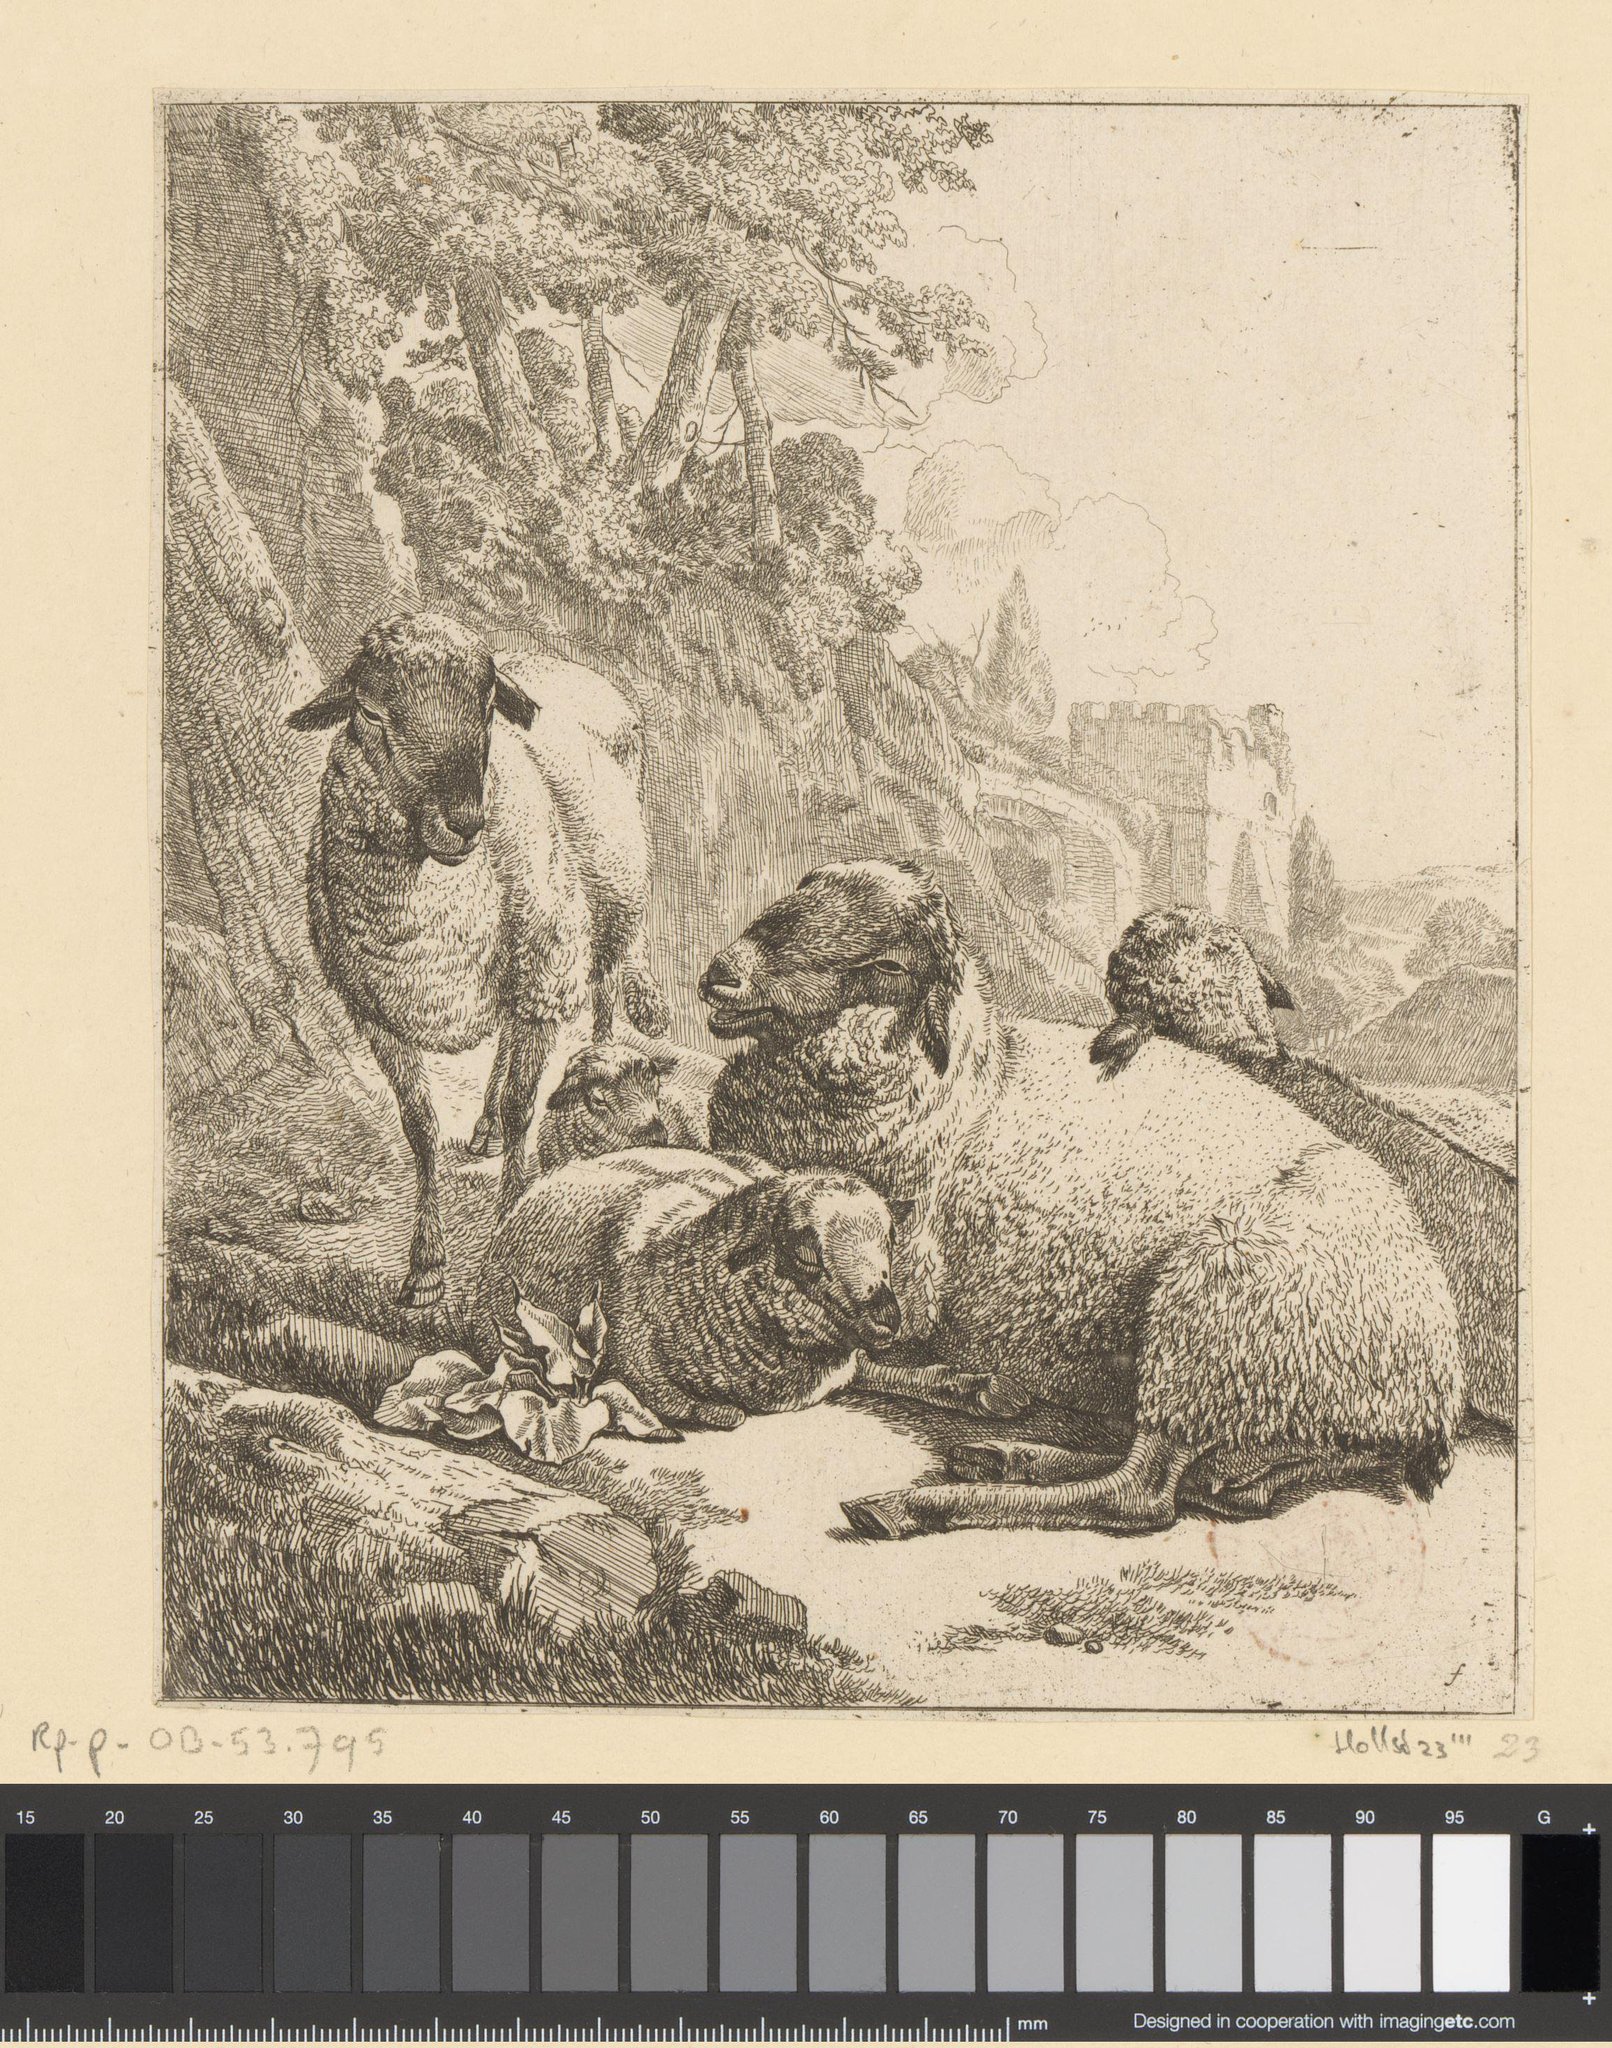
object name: print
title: Staand schaap en drie liggende schapen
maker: johann heinrich roos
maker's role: draughtsman, print maker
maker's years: 1631-1685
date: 1668-1670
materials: paper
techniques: engraving, etching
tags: landscapes, sheep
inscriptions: collector's mark: Lugt 240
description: Serie van twaalf prenten, waarvan één titelprent.